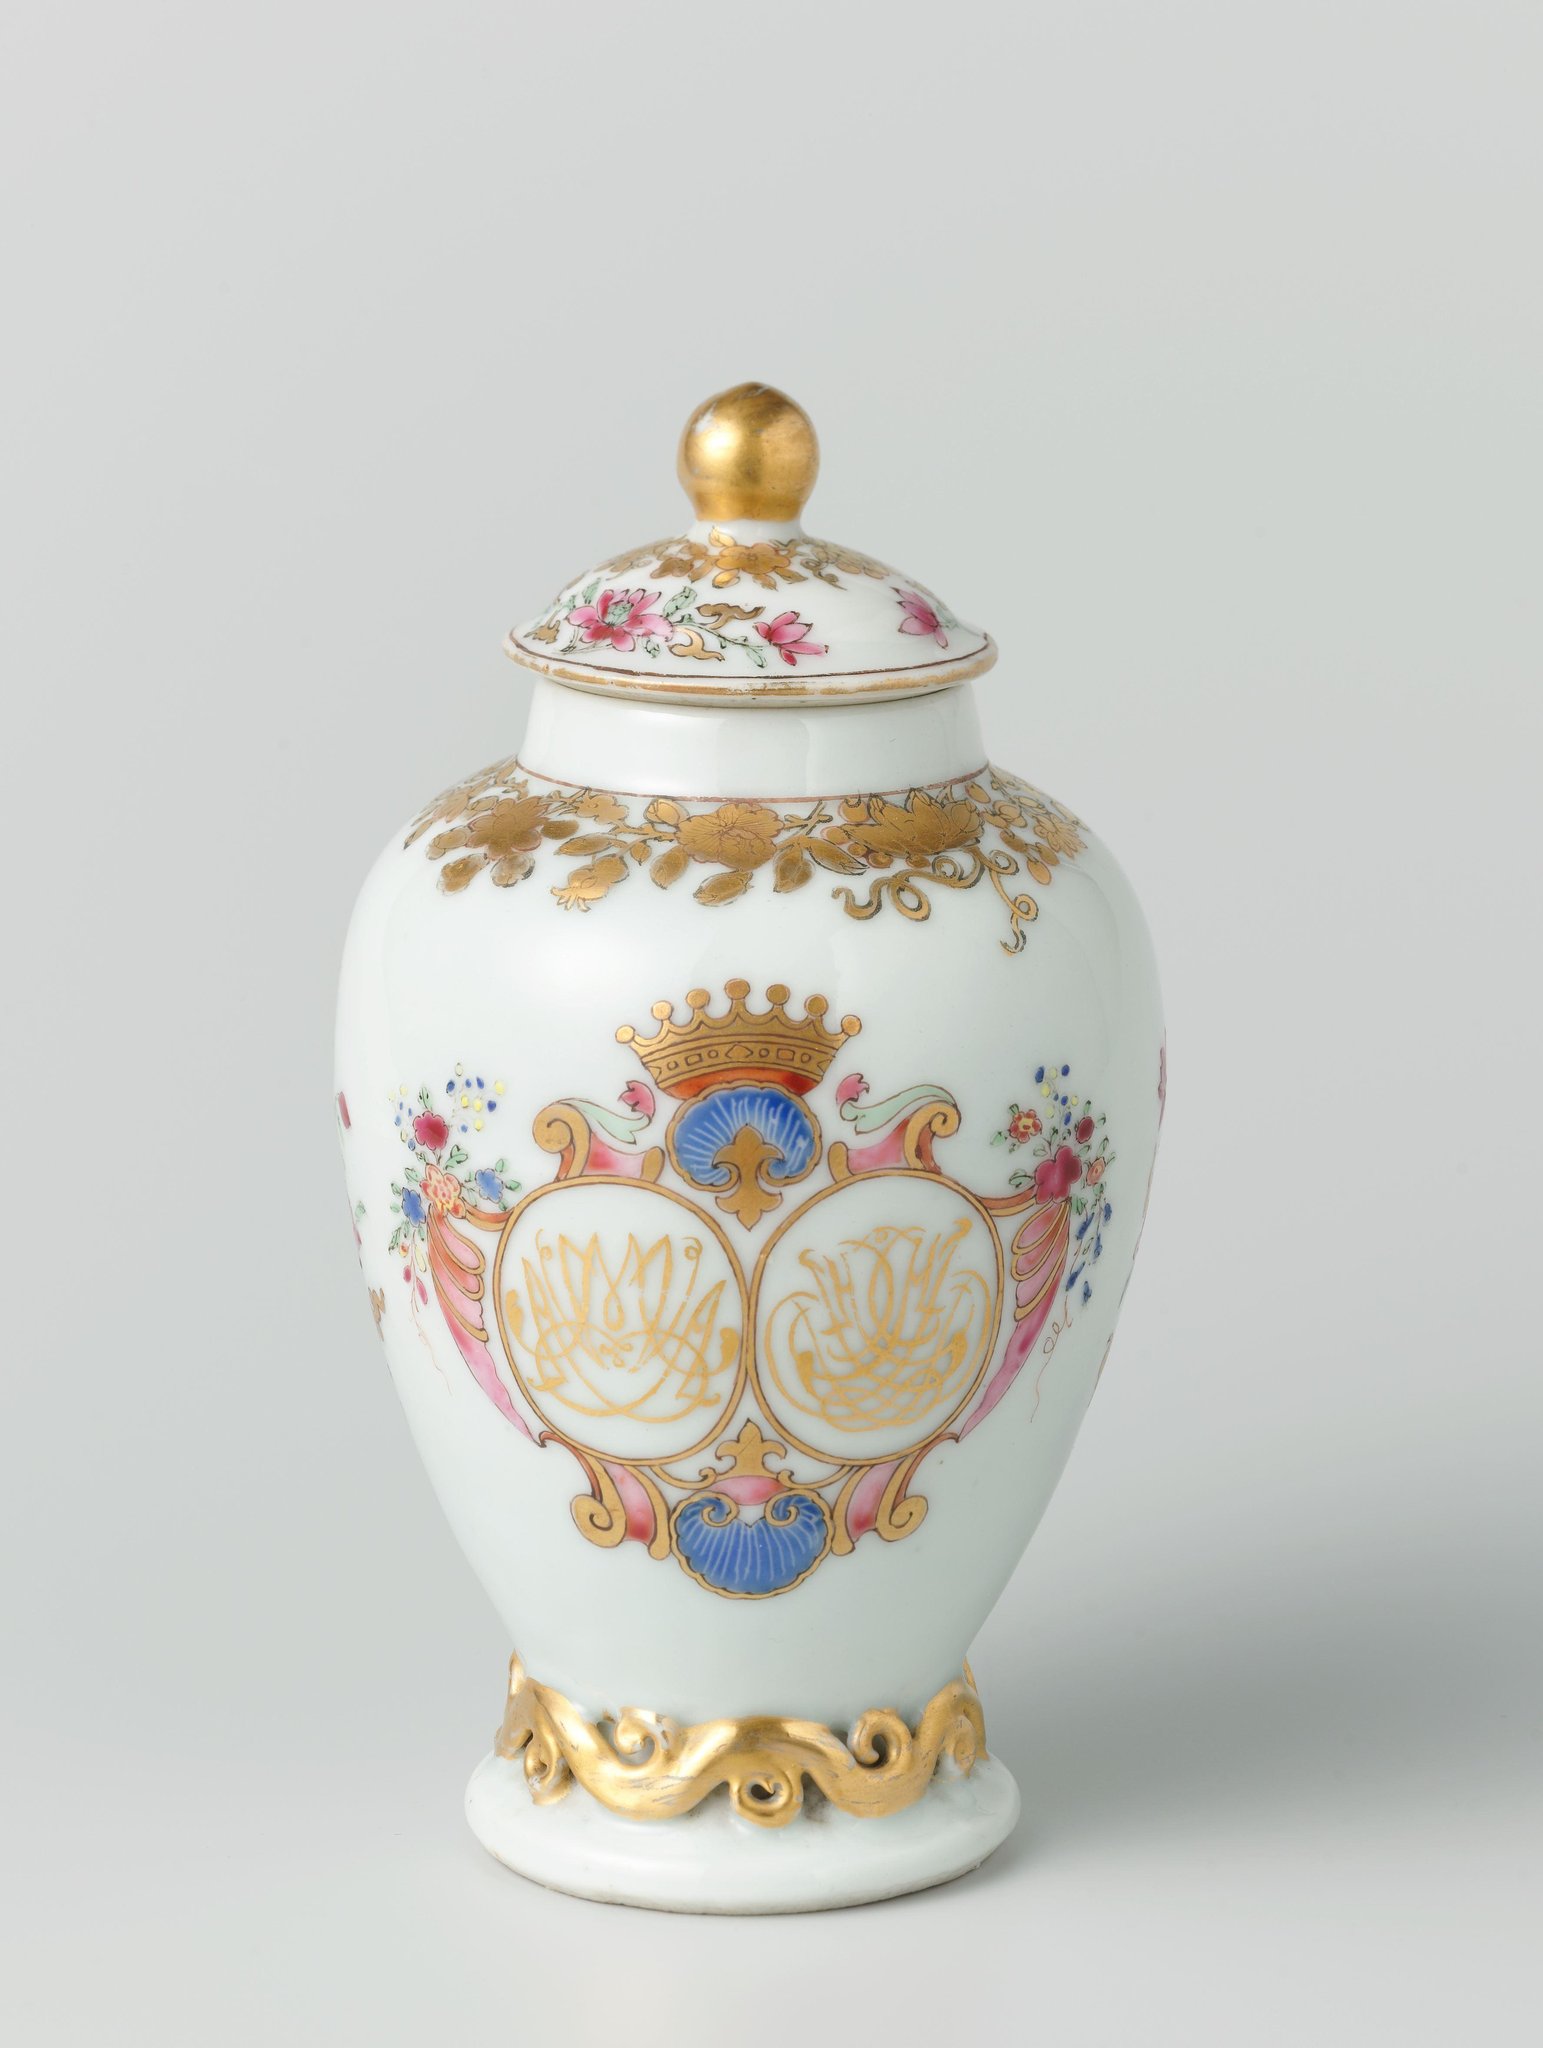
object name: tea caddy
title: Ovoid tea caddy with handle from the 'Swellengrebel service' with a double crowned monogram and a border with floral scrolls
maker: Anonymous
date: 1740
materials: glaze, gold, paint, porcelain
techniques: firing, forming, gilding, turning, vitrification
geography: china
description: De monogrammen 'MVA' en 'CHTD' staan voor Maurits van Aerden (1694-1746) en Constantia Helena ten Damme (1694-1772), getrouwd in 1716. Het servies is waarschijnlijk besteld ter ere van hun vijfentwingtigjarig huwelijksjubileum in 1741. (Campen, Jan van & Hartkamp-Jonxis, Ebeltje, Aziatische weelde : VOC-kunst in het Rijksmuseum, Zutphen 2011, p. 78)